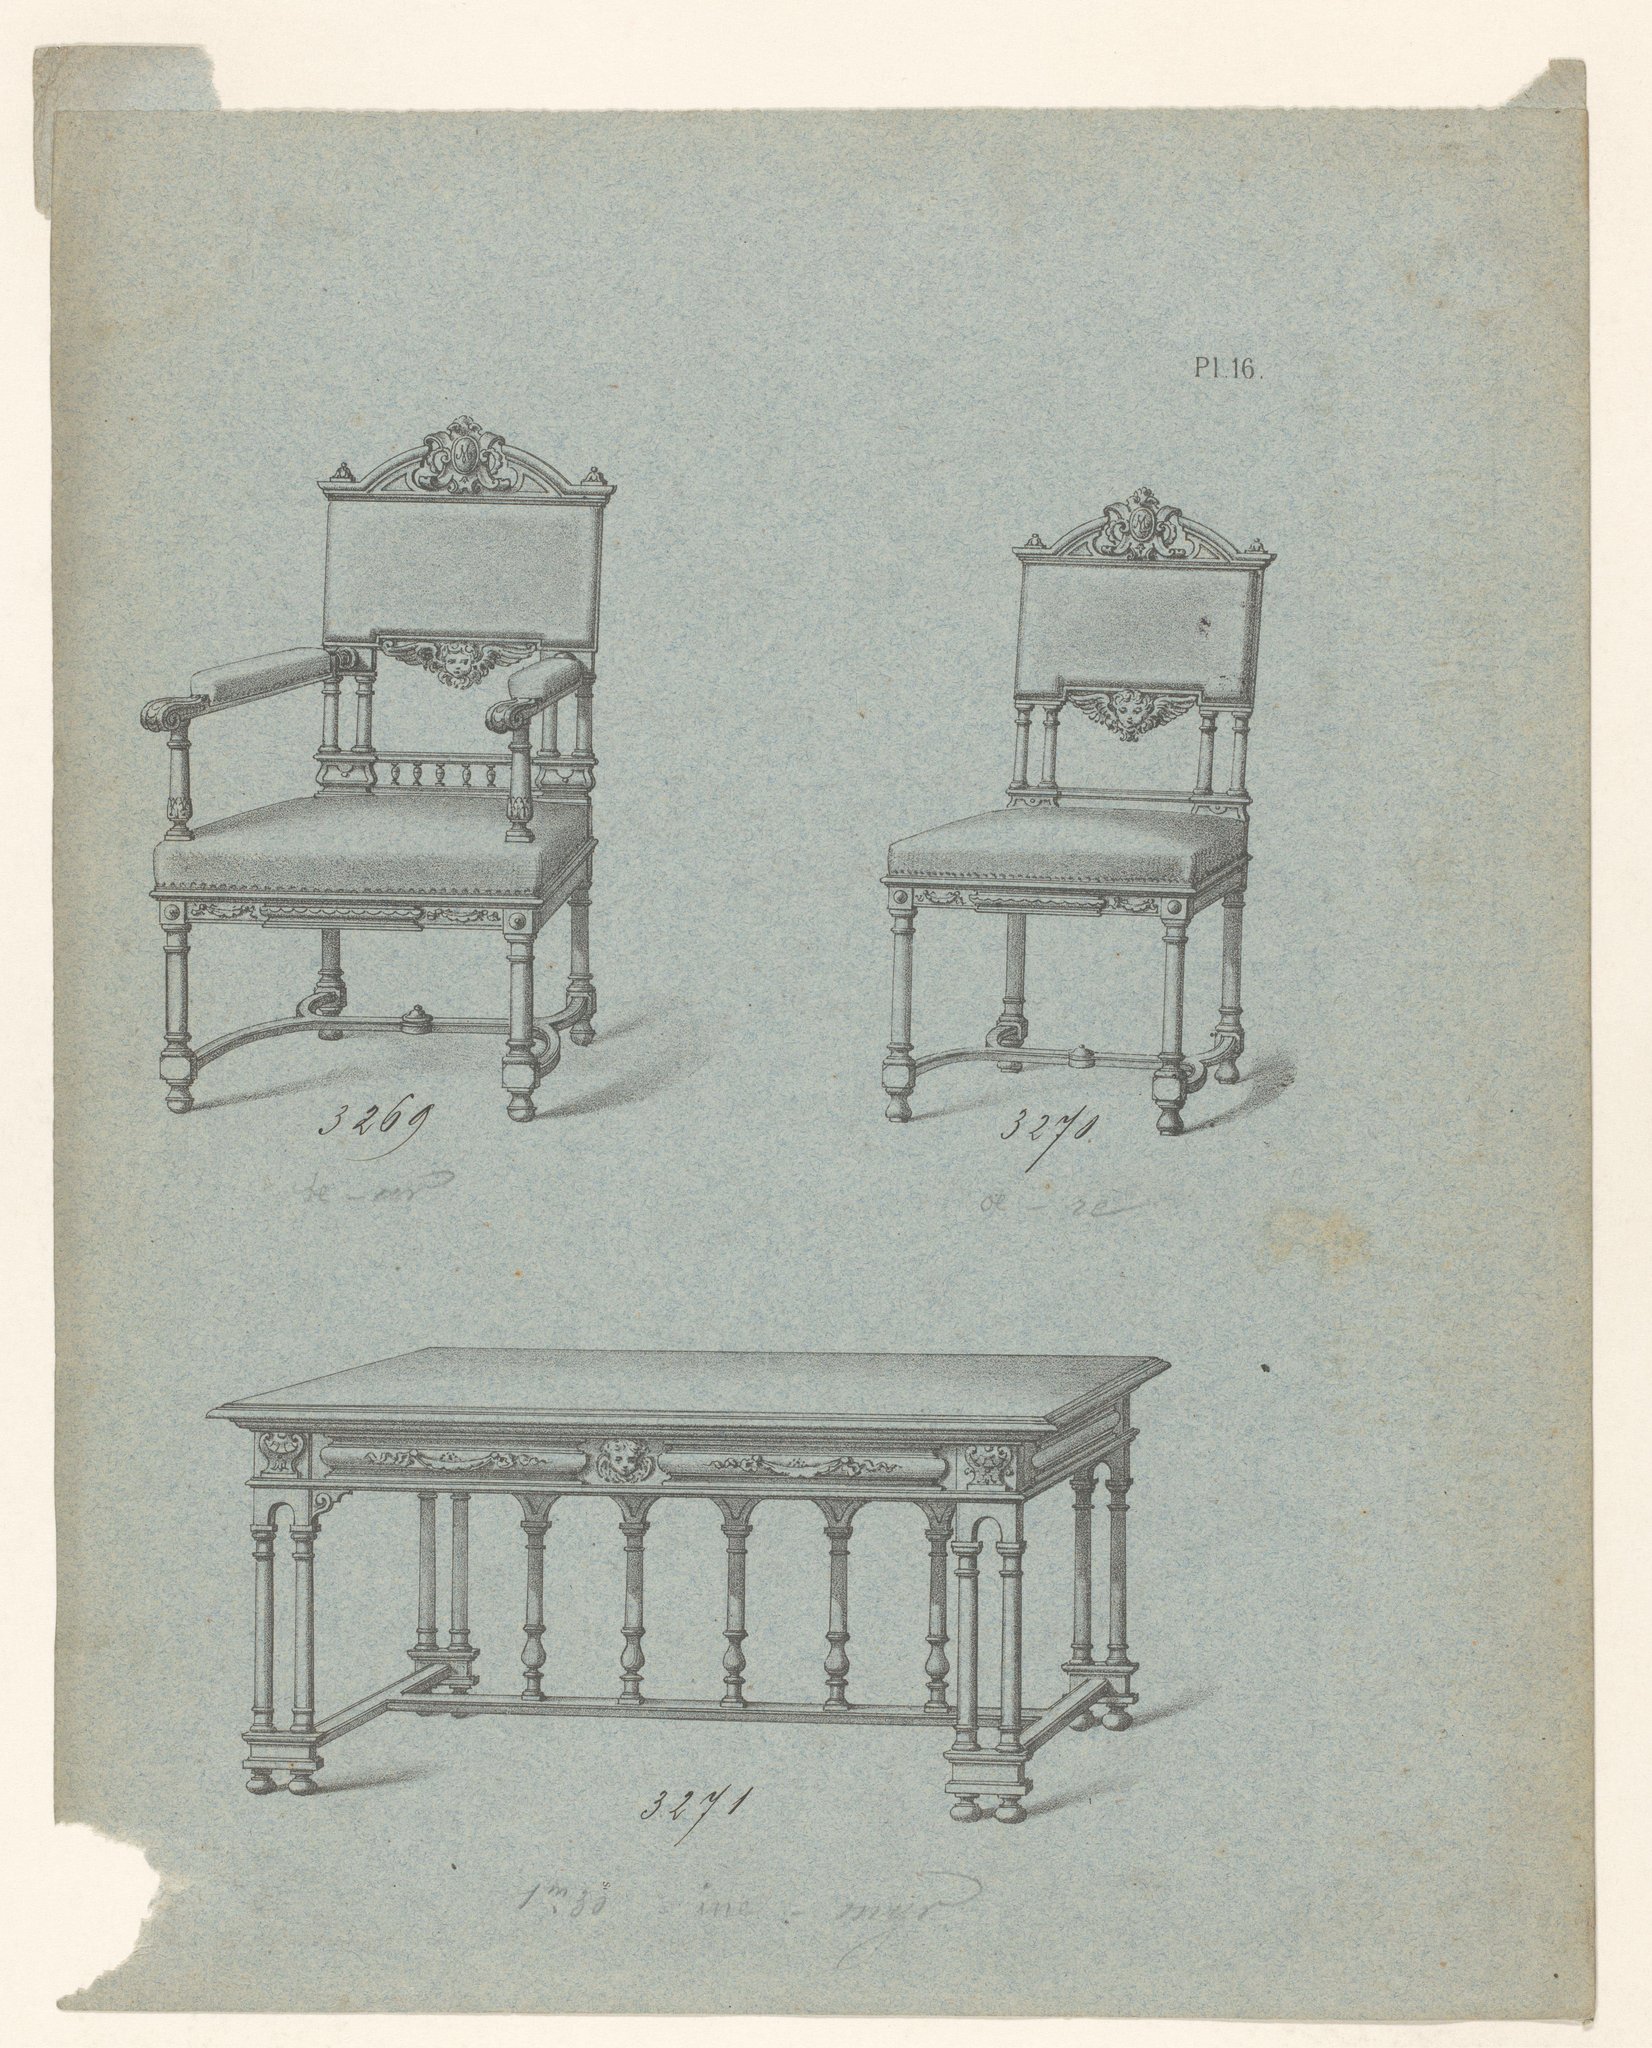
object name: print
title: Fauteuil, stoel en tafel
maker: Anonymous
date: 1800-1900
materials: paper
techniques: lithograph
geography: france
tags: seating furniture, table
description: Een fauteuil, stoel en rechthoekige tafel.